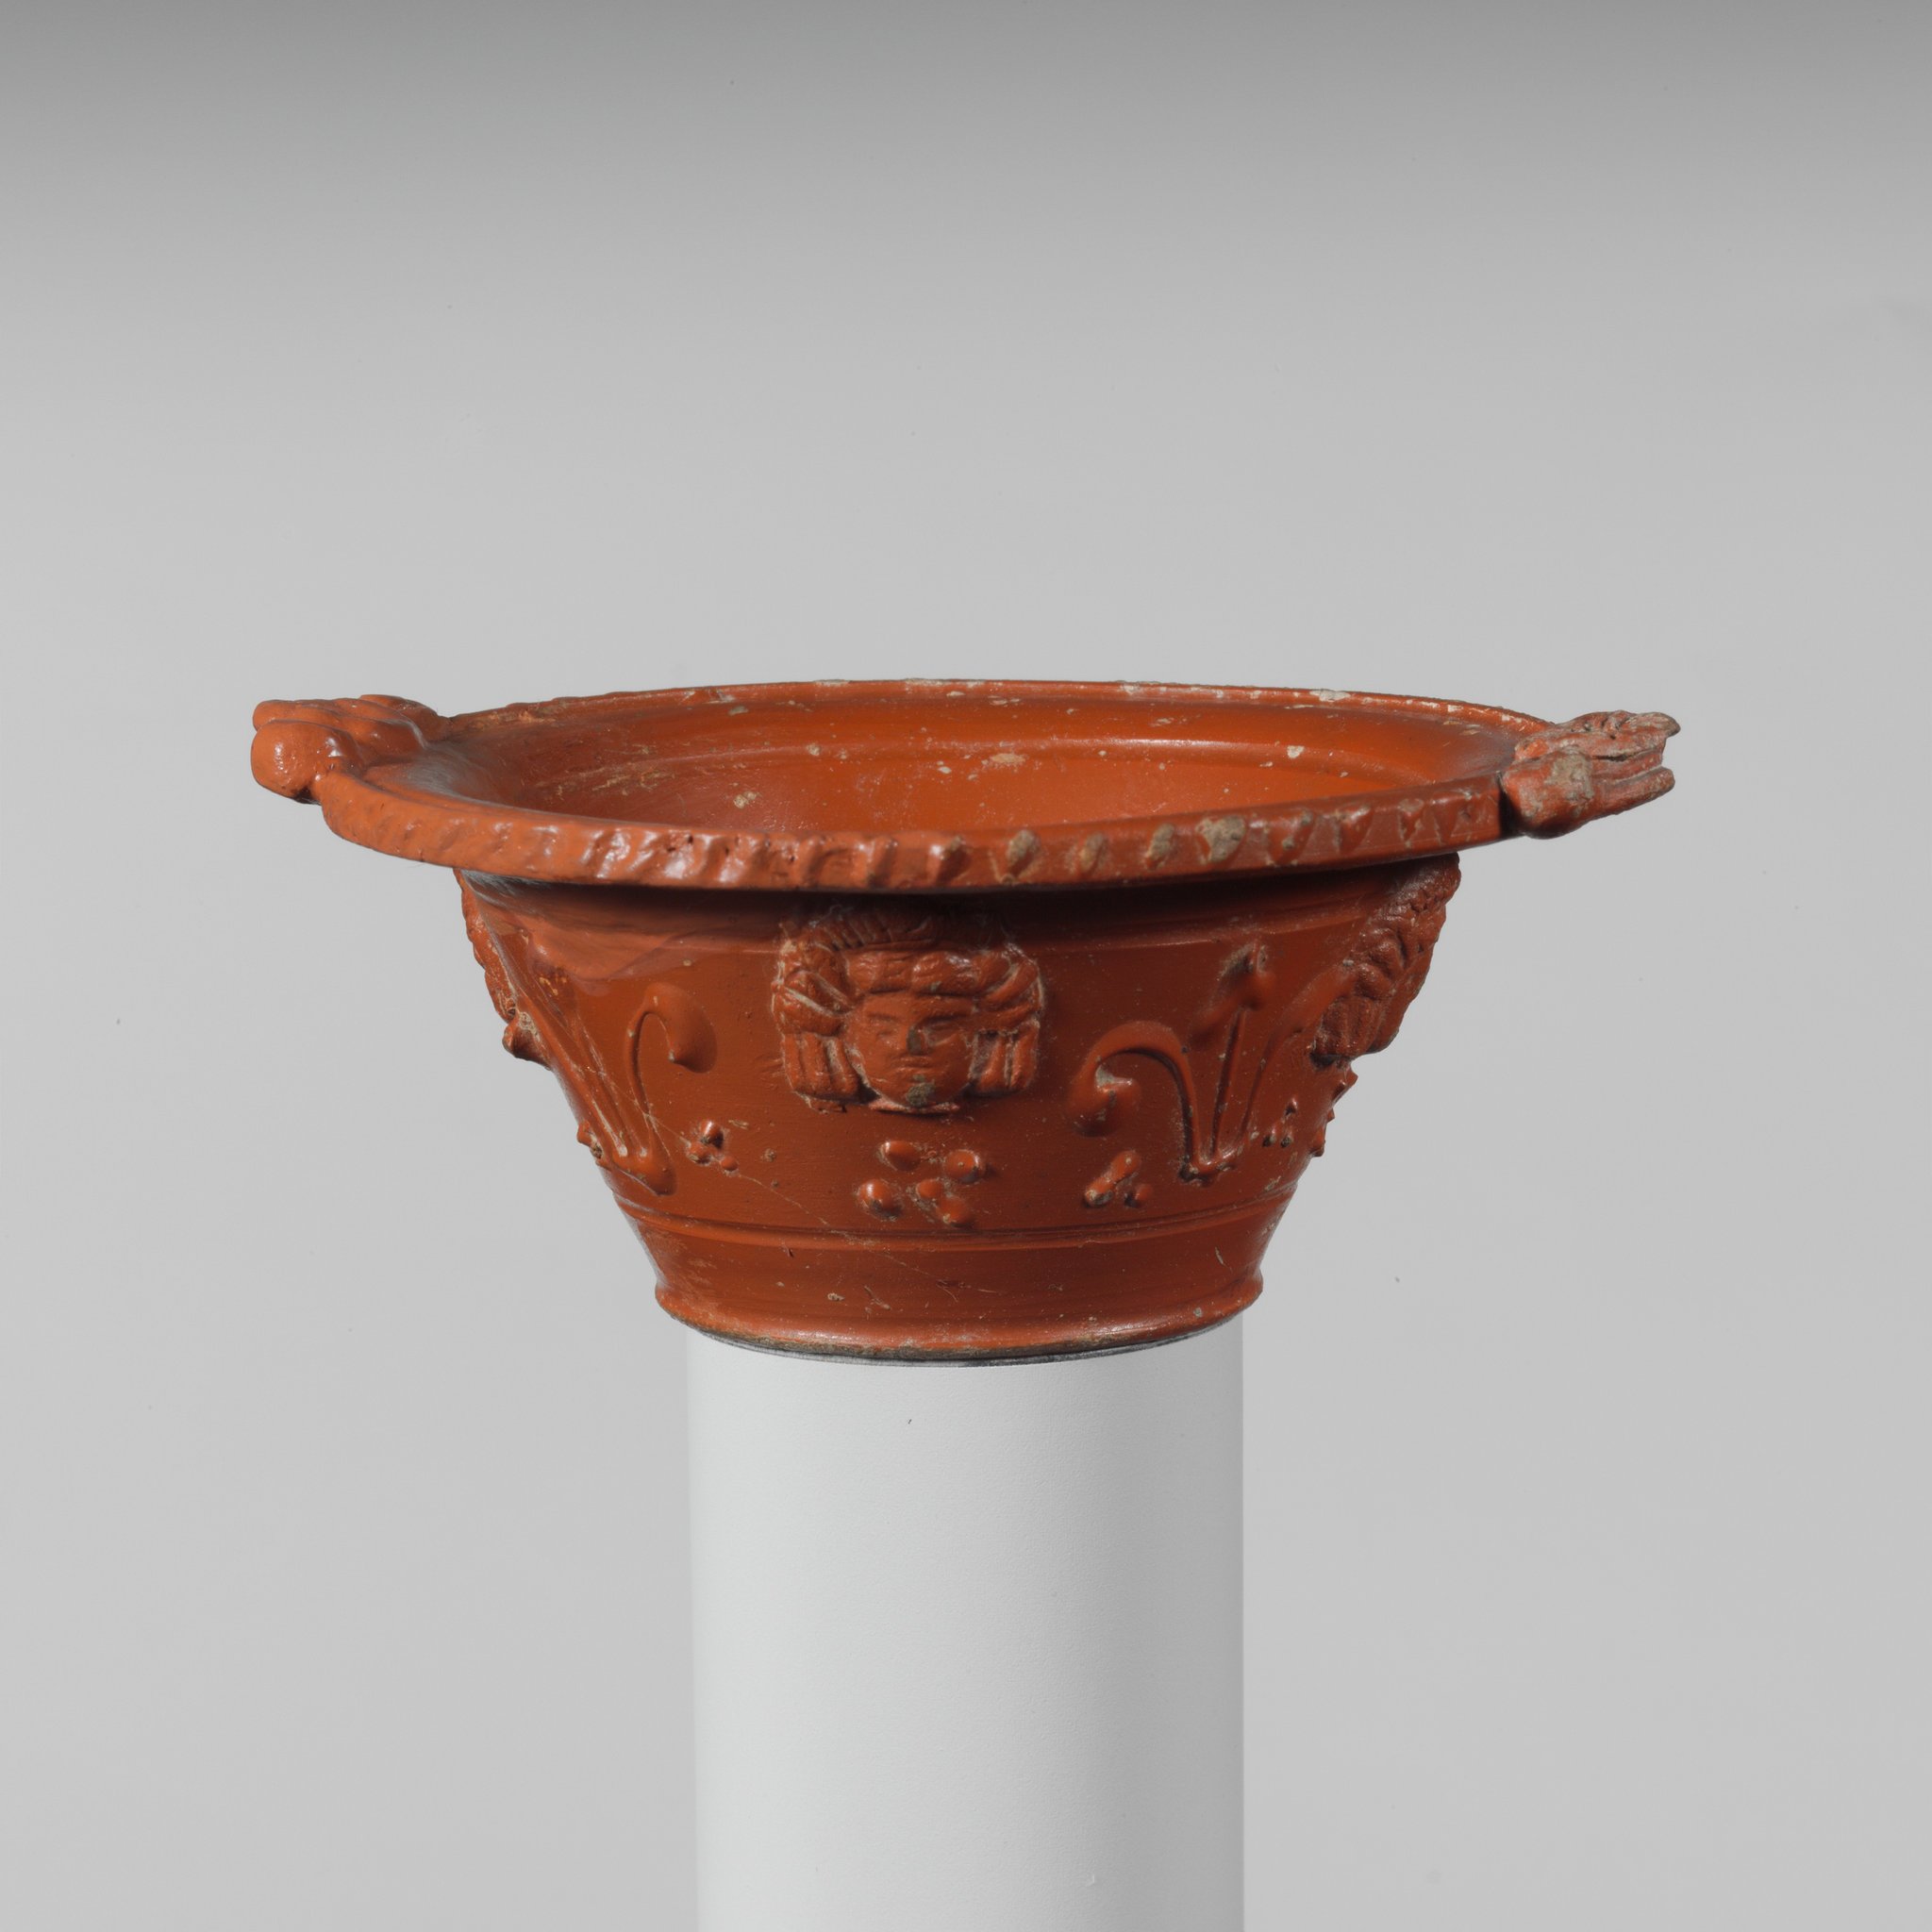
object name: cup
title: Terracotta cup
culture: roman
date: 70-150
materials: terracotta